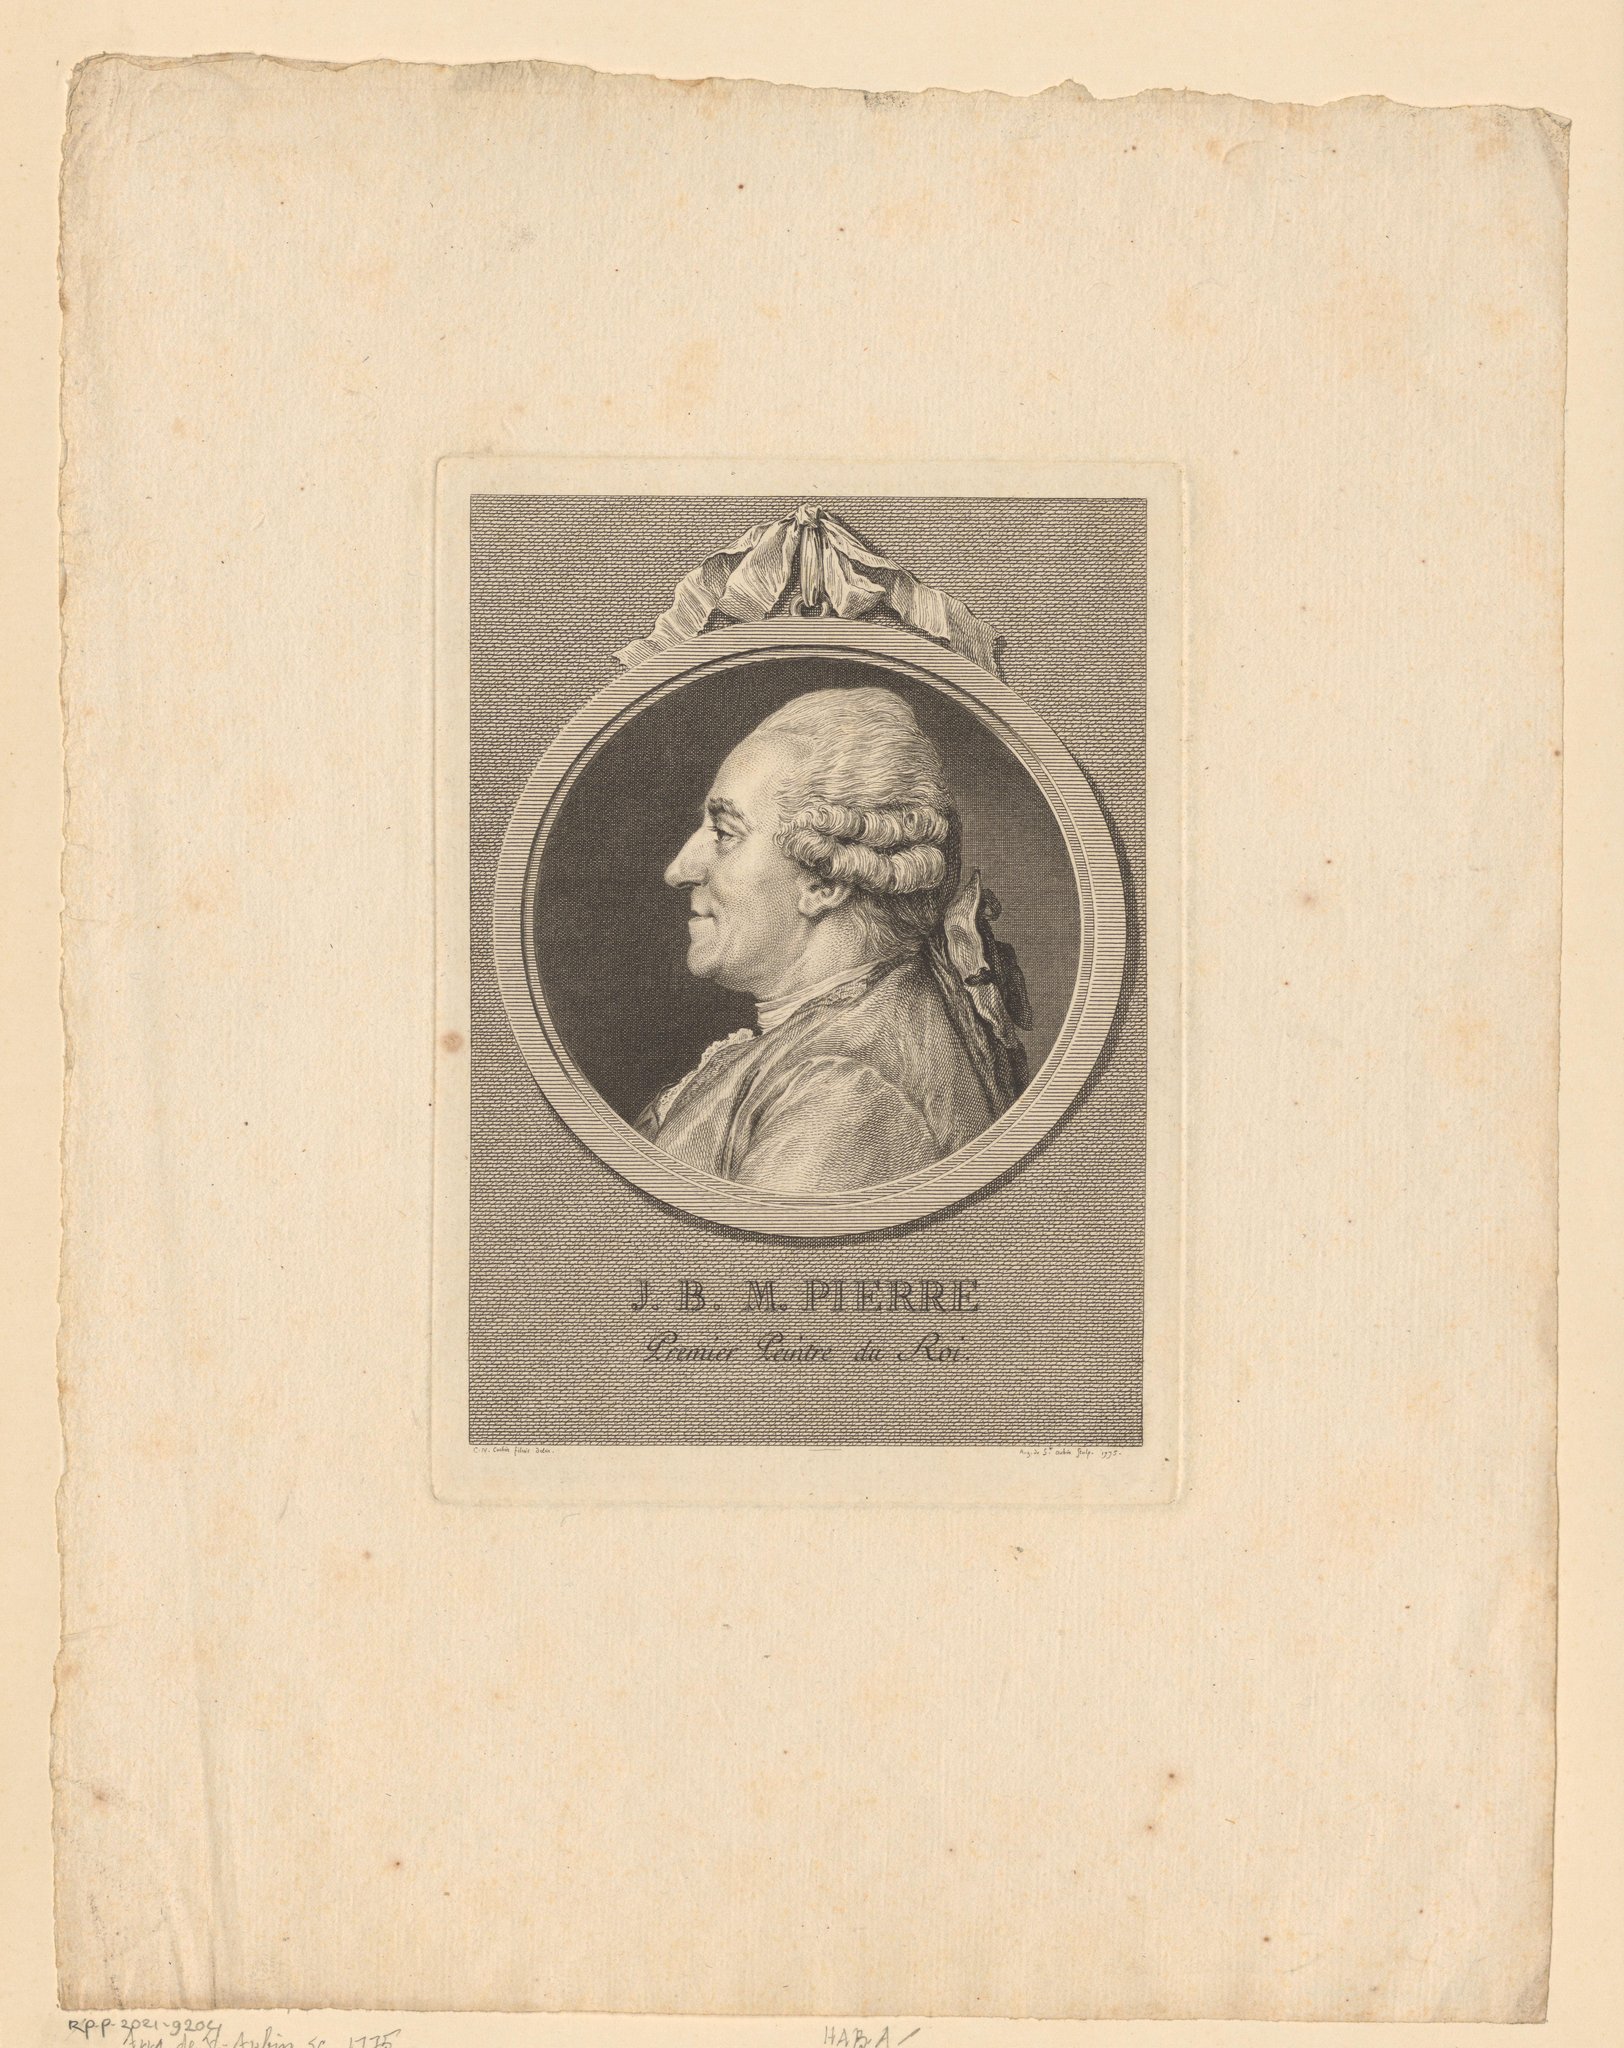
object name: print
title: Portret van Jean Baptiste Marie Pierre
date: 1775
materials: paper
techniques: engraving, etching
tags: paris, print maker, jean baptiste marie pierre, adult man, historical persons, portrait, self-portrait of graphic artist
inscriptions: date